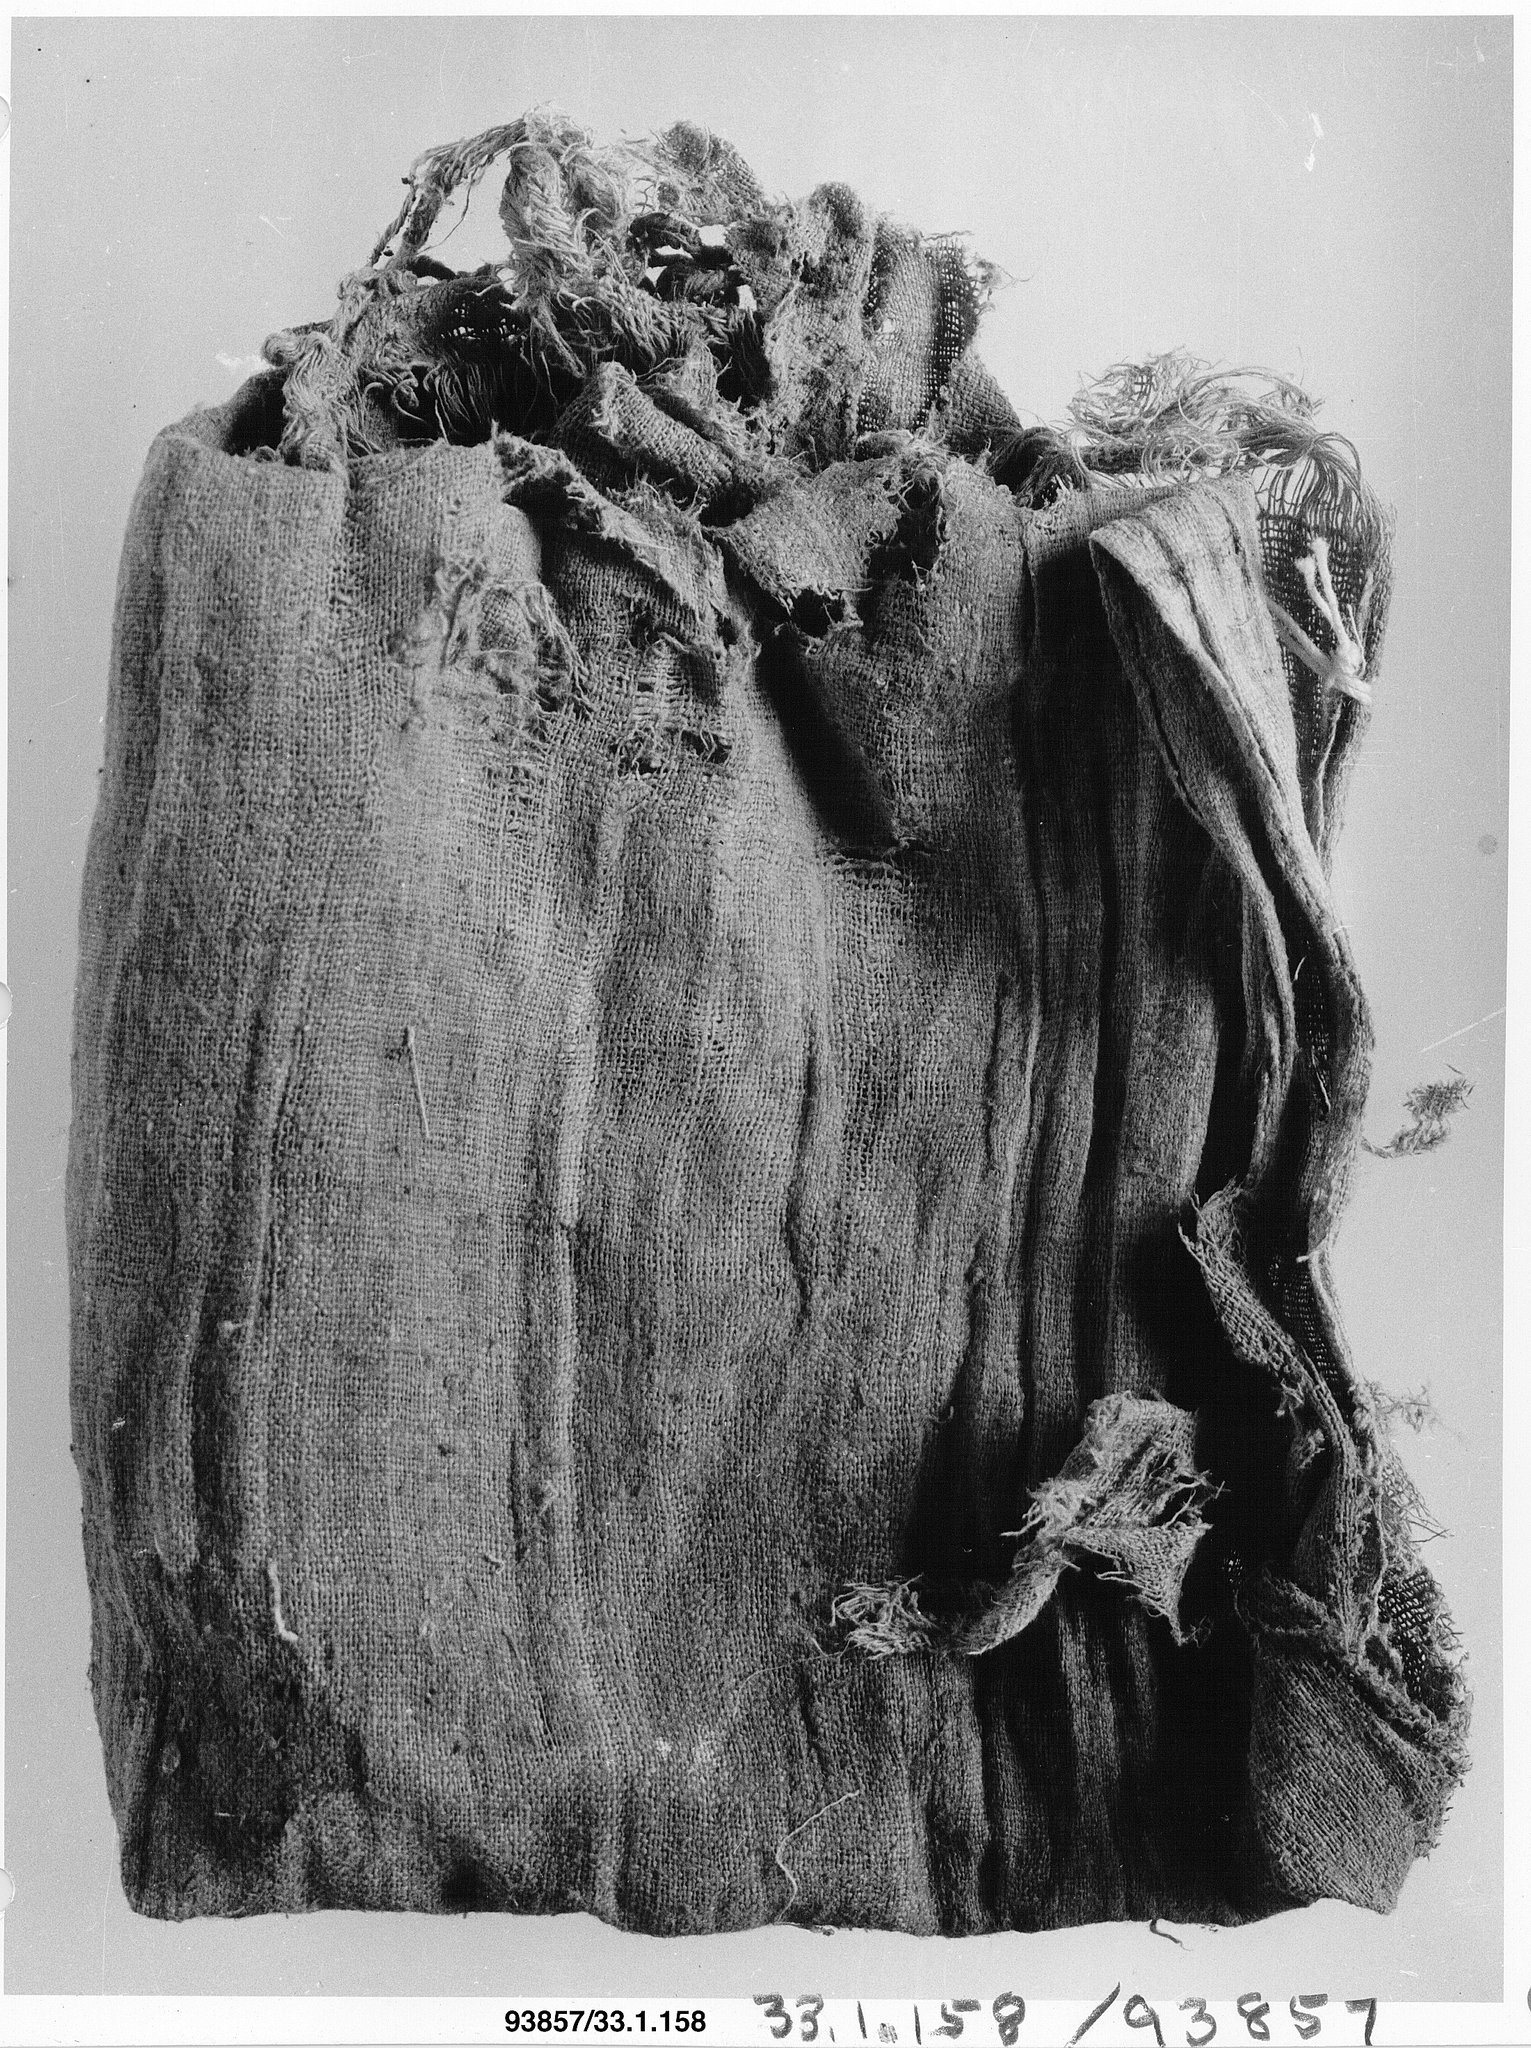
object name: fragment of a sheet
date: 401-500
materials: linen, wool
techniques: tapestry, weave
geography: egypt